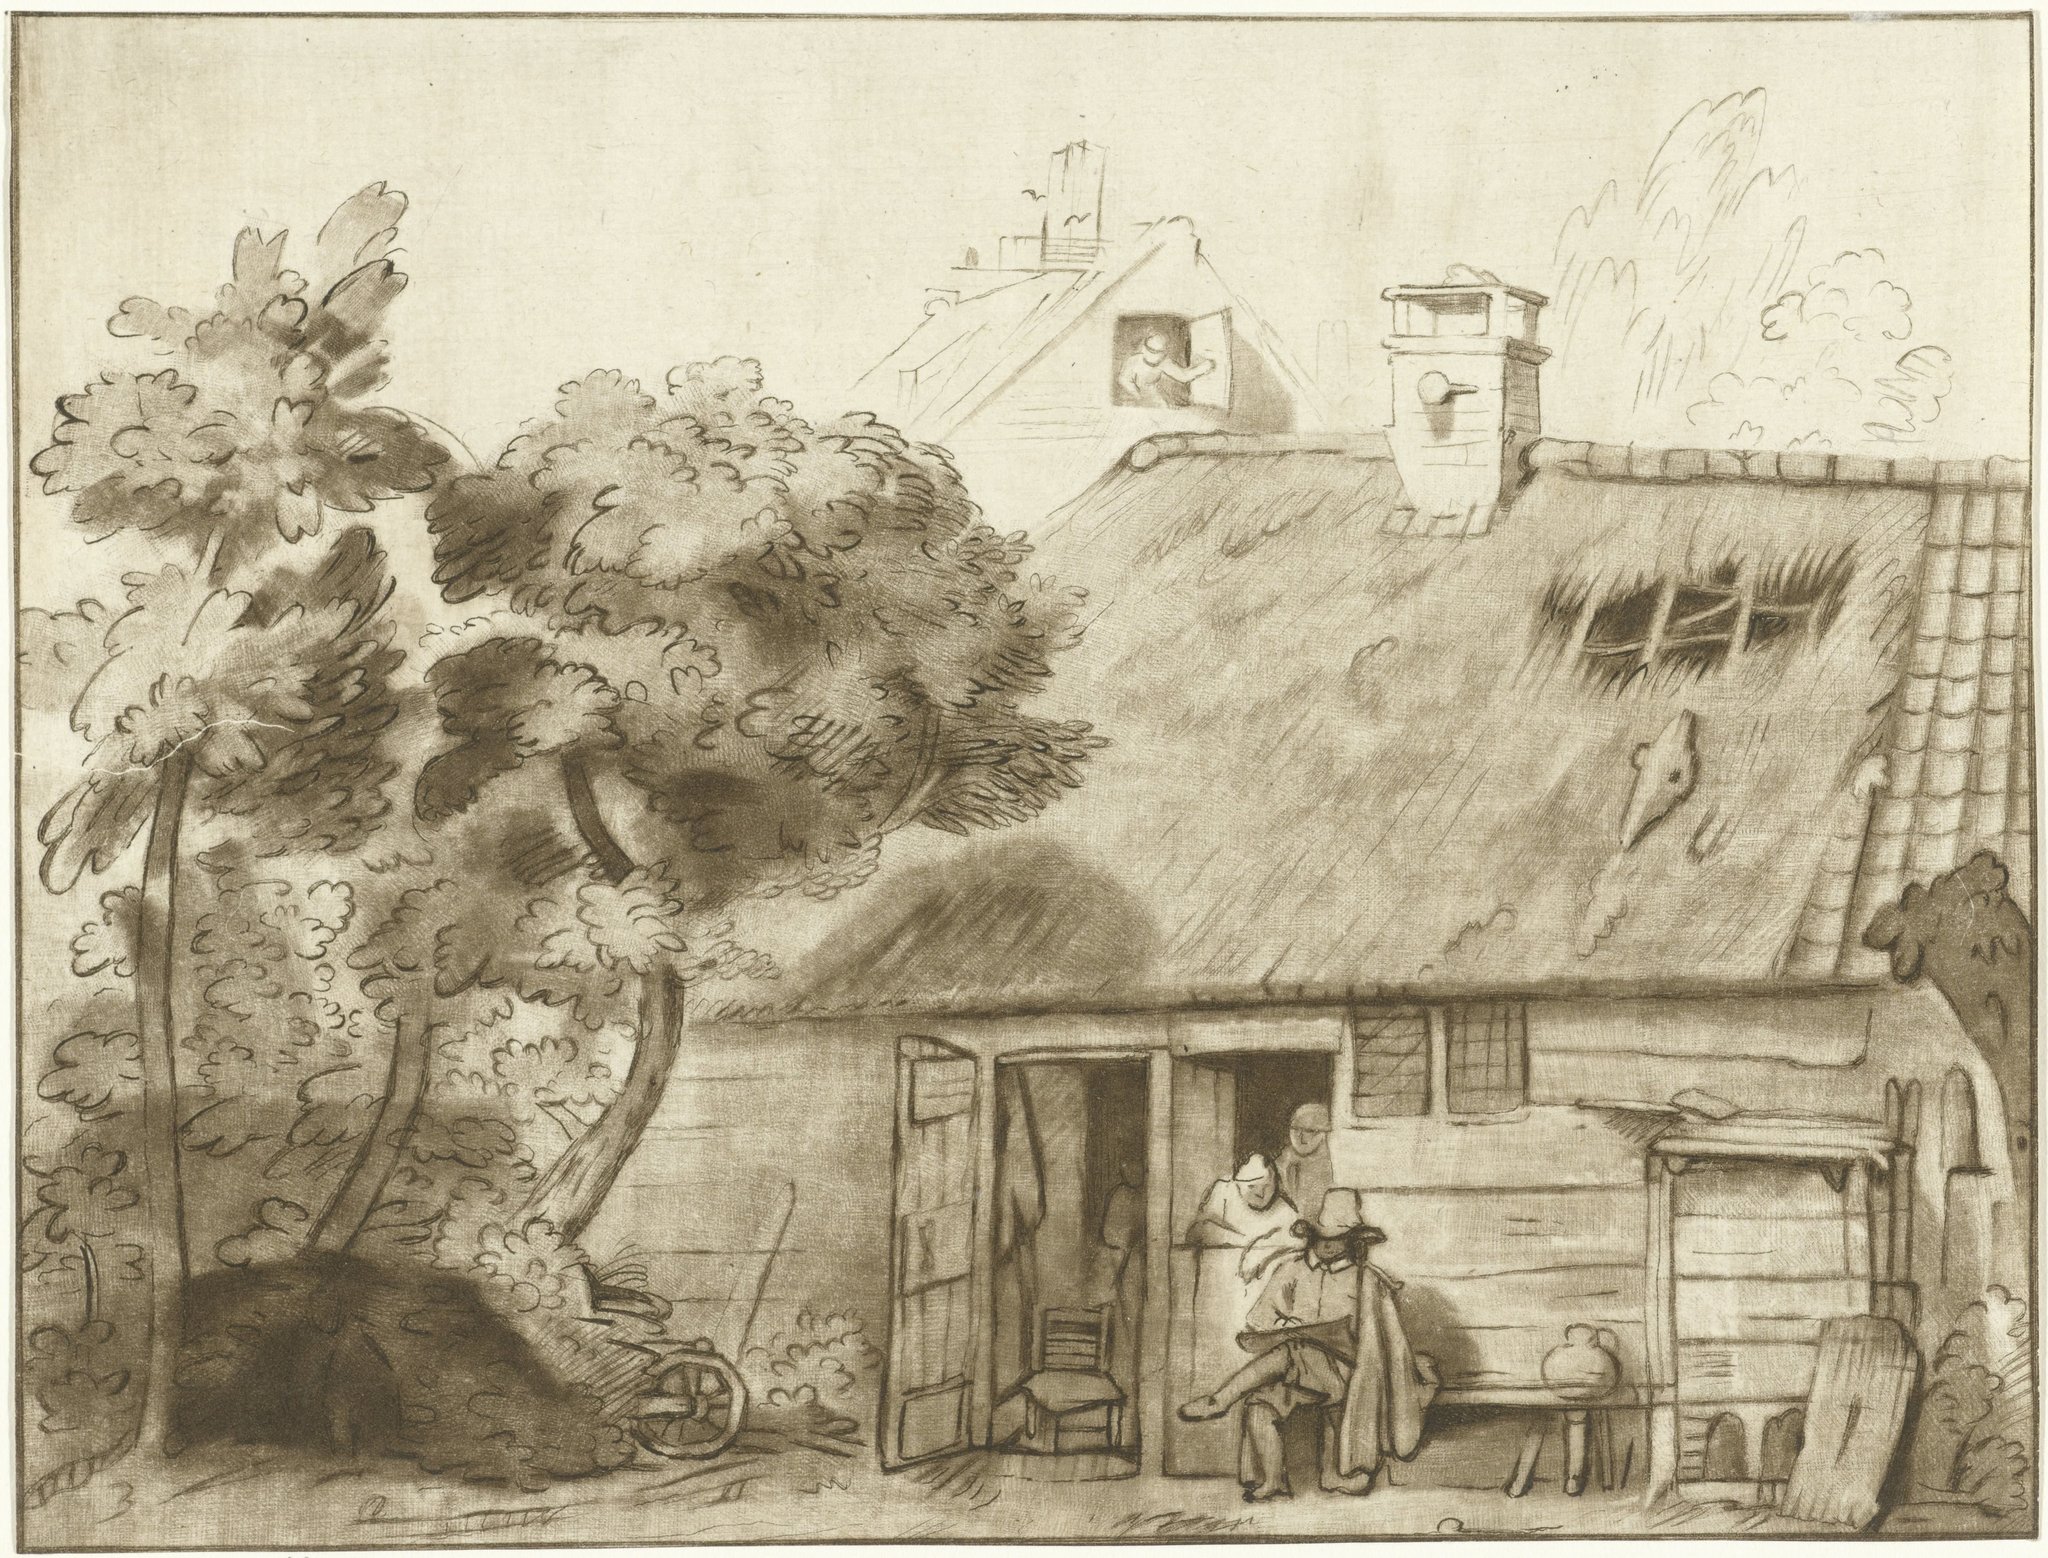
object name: print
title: Tekenaar voor boerderij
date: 1767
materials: paper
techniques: etching, roulette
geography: amsterdam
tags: draughtsman at work - cc - out of doors, farm (building)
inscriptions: inscription: ‘Geoffreerd aan de WEd Geb Heer J: L vd Dussen mijne geagte neef / Gerb. van den Eekhout del Ploos v Amstel F 1767’, date, collector's mark: Lugt 240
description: Een tekenaar zit op een bankje voor een boerderij. Twee mensen leunen op de onderdeur.